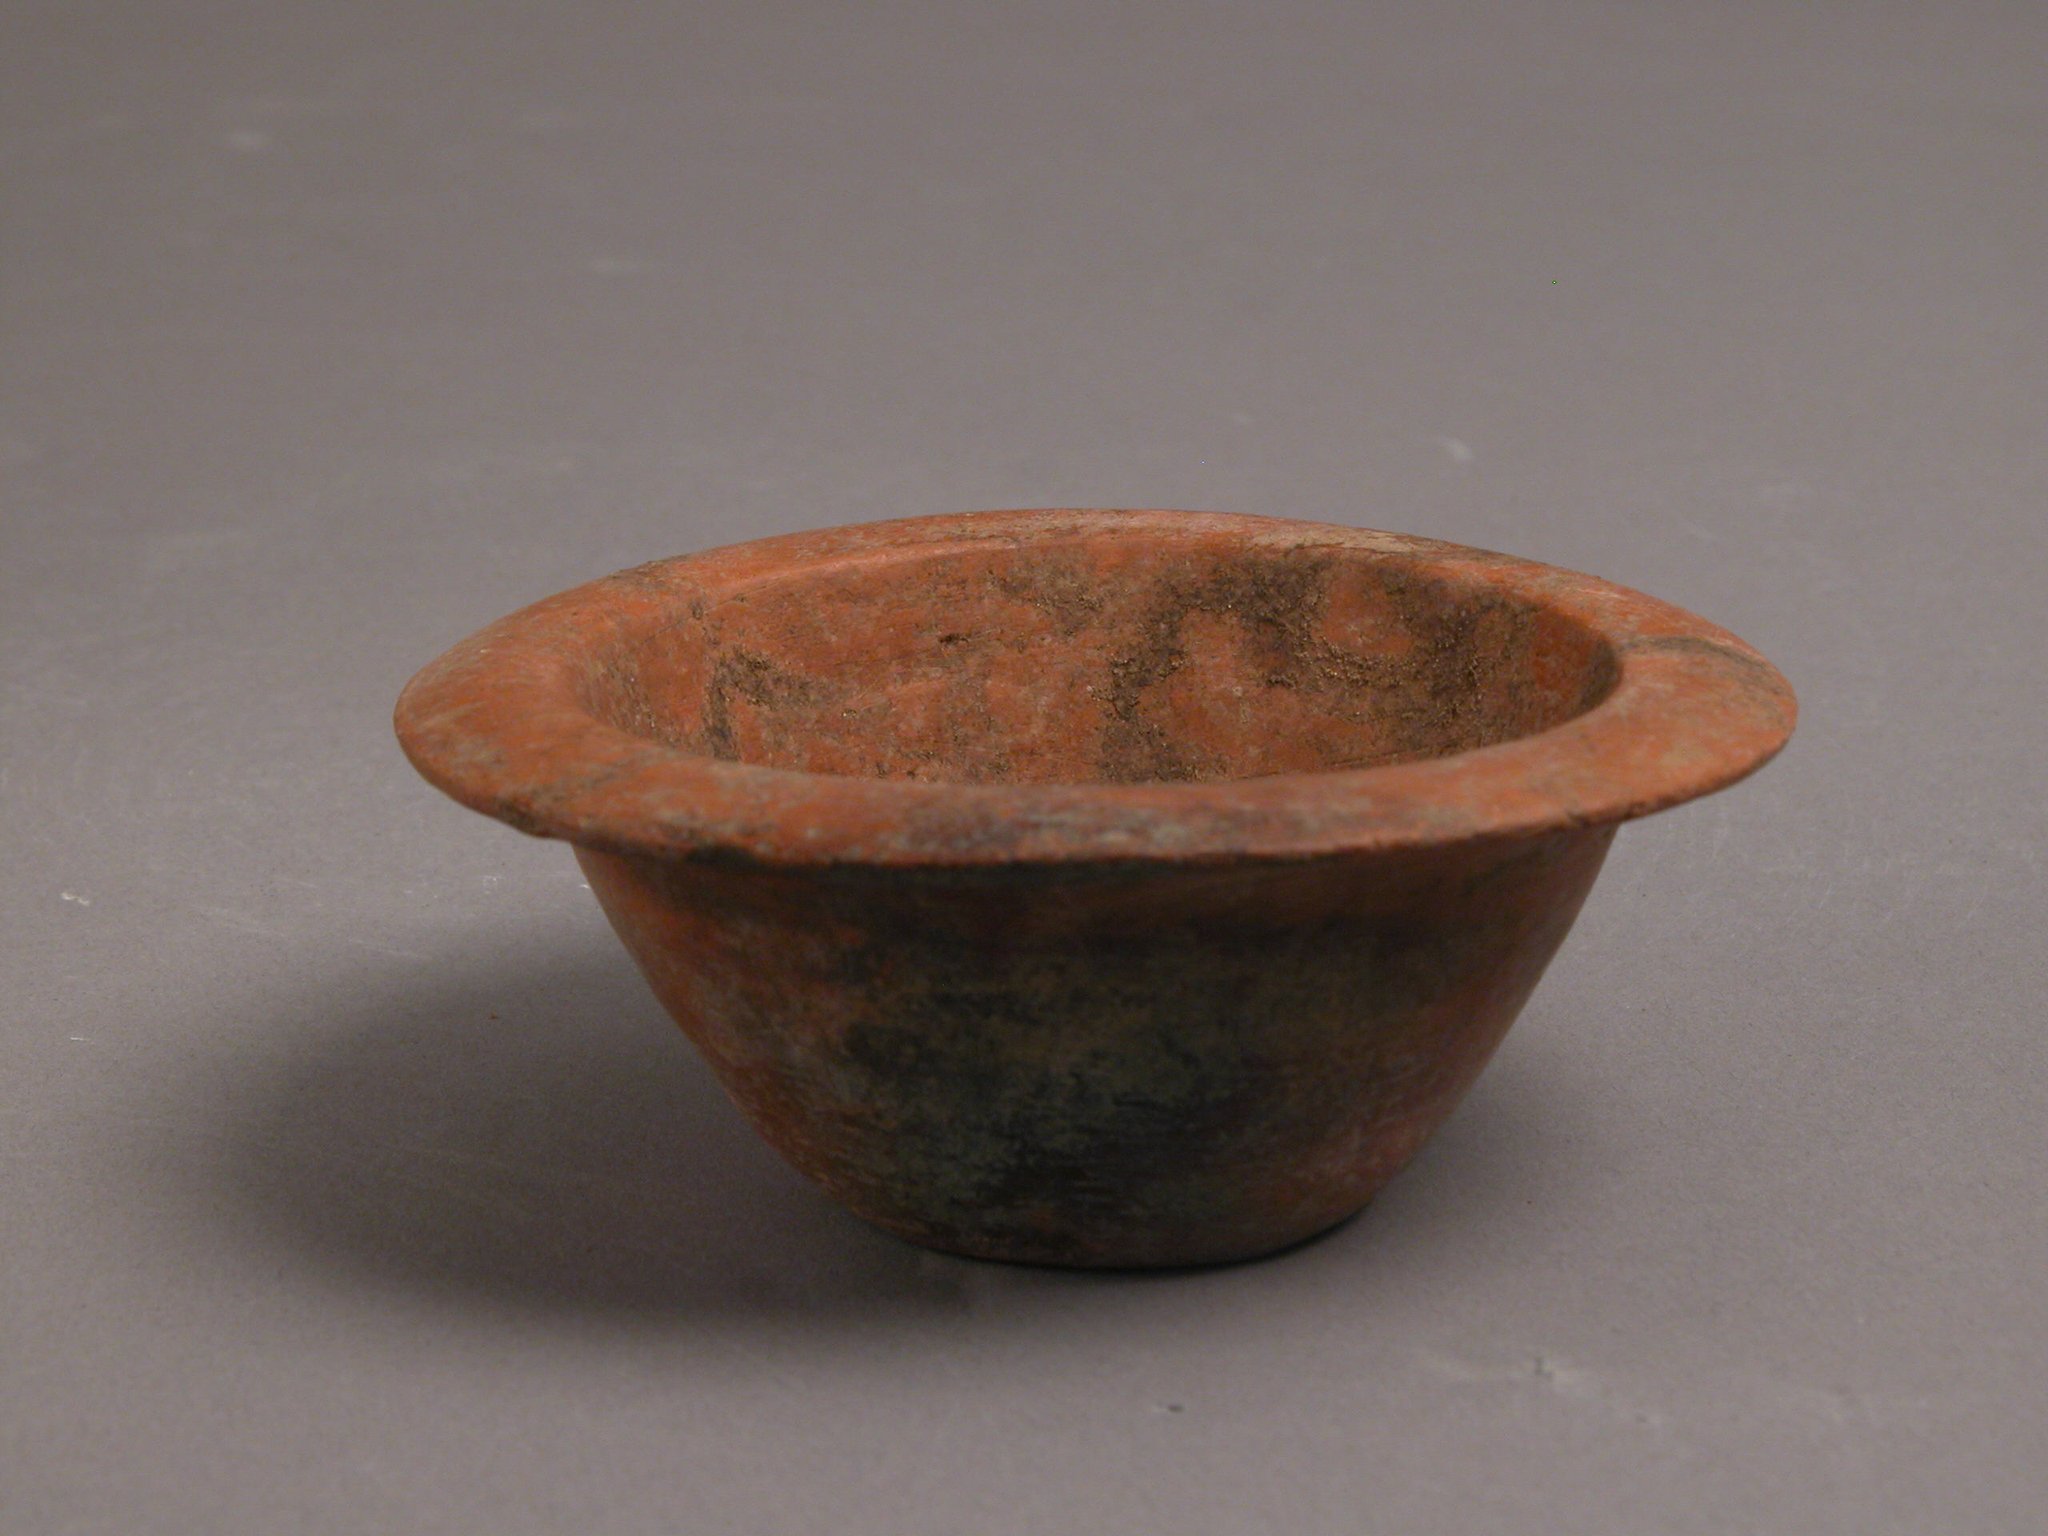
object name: bowl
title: Nesting Bowl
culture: coptic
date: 301-700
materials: earthenware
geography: egypt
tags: bowls